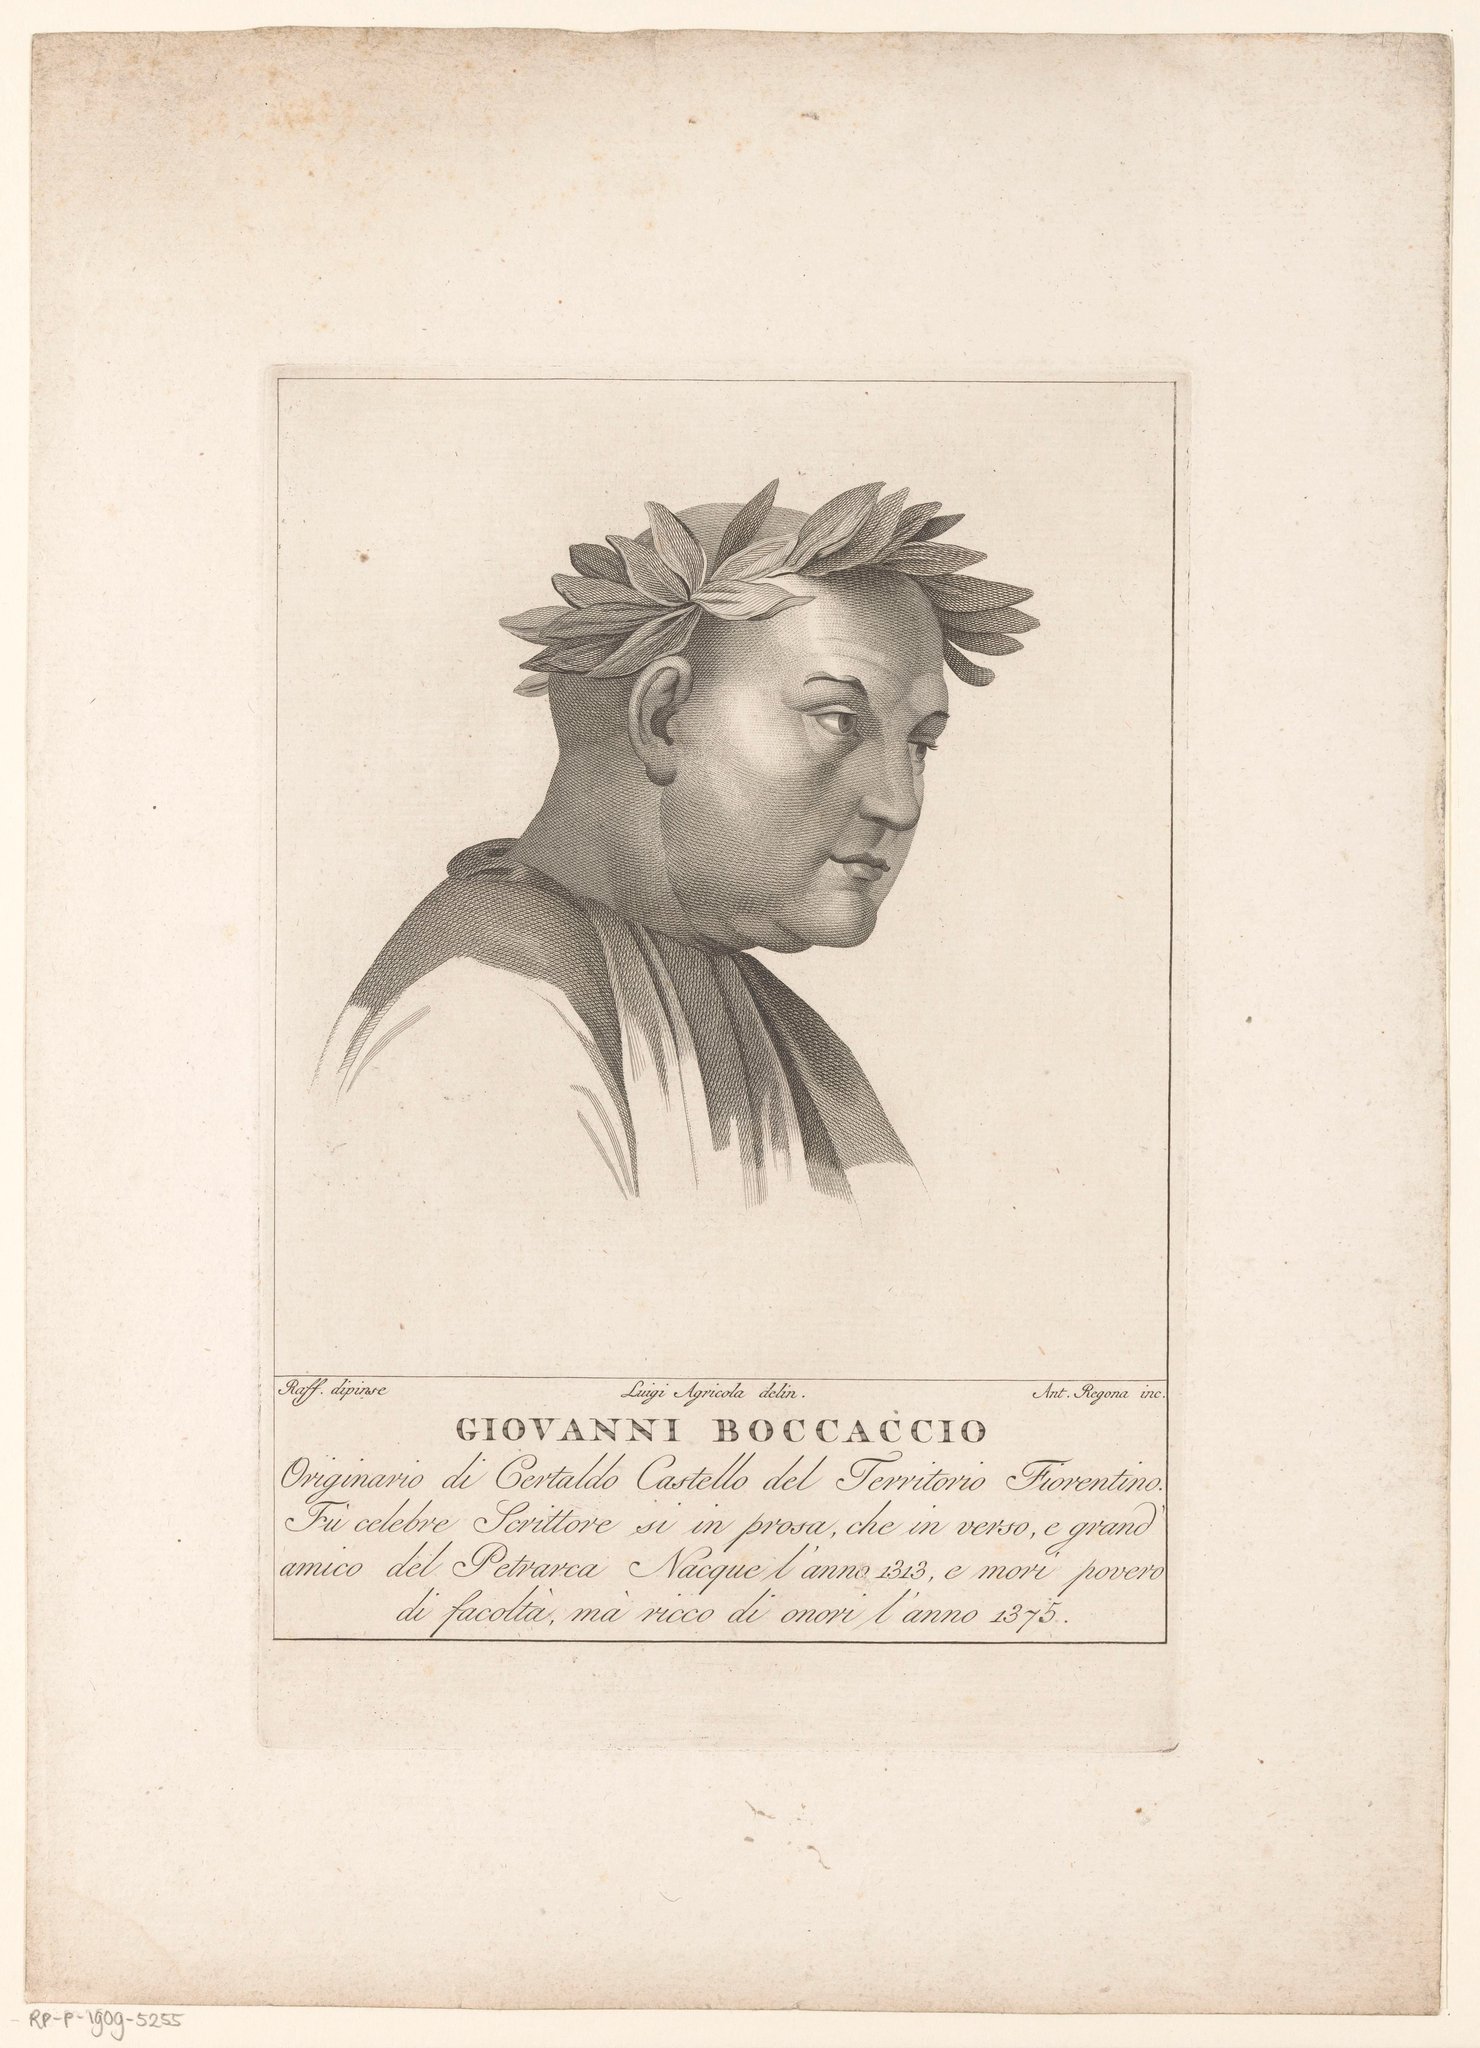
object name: print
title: Portret van dichter en schrijver Giovanni Boccaccio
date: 1770-1853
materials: paper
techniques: etching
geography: italy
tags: giovanni boccaccio, historical persons, portrait of a writer, writer, poet, author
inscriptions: collector's mark: Lugt 2228